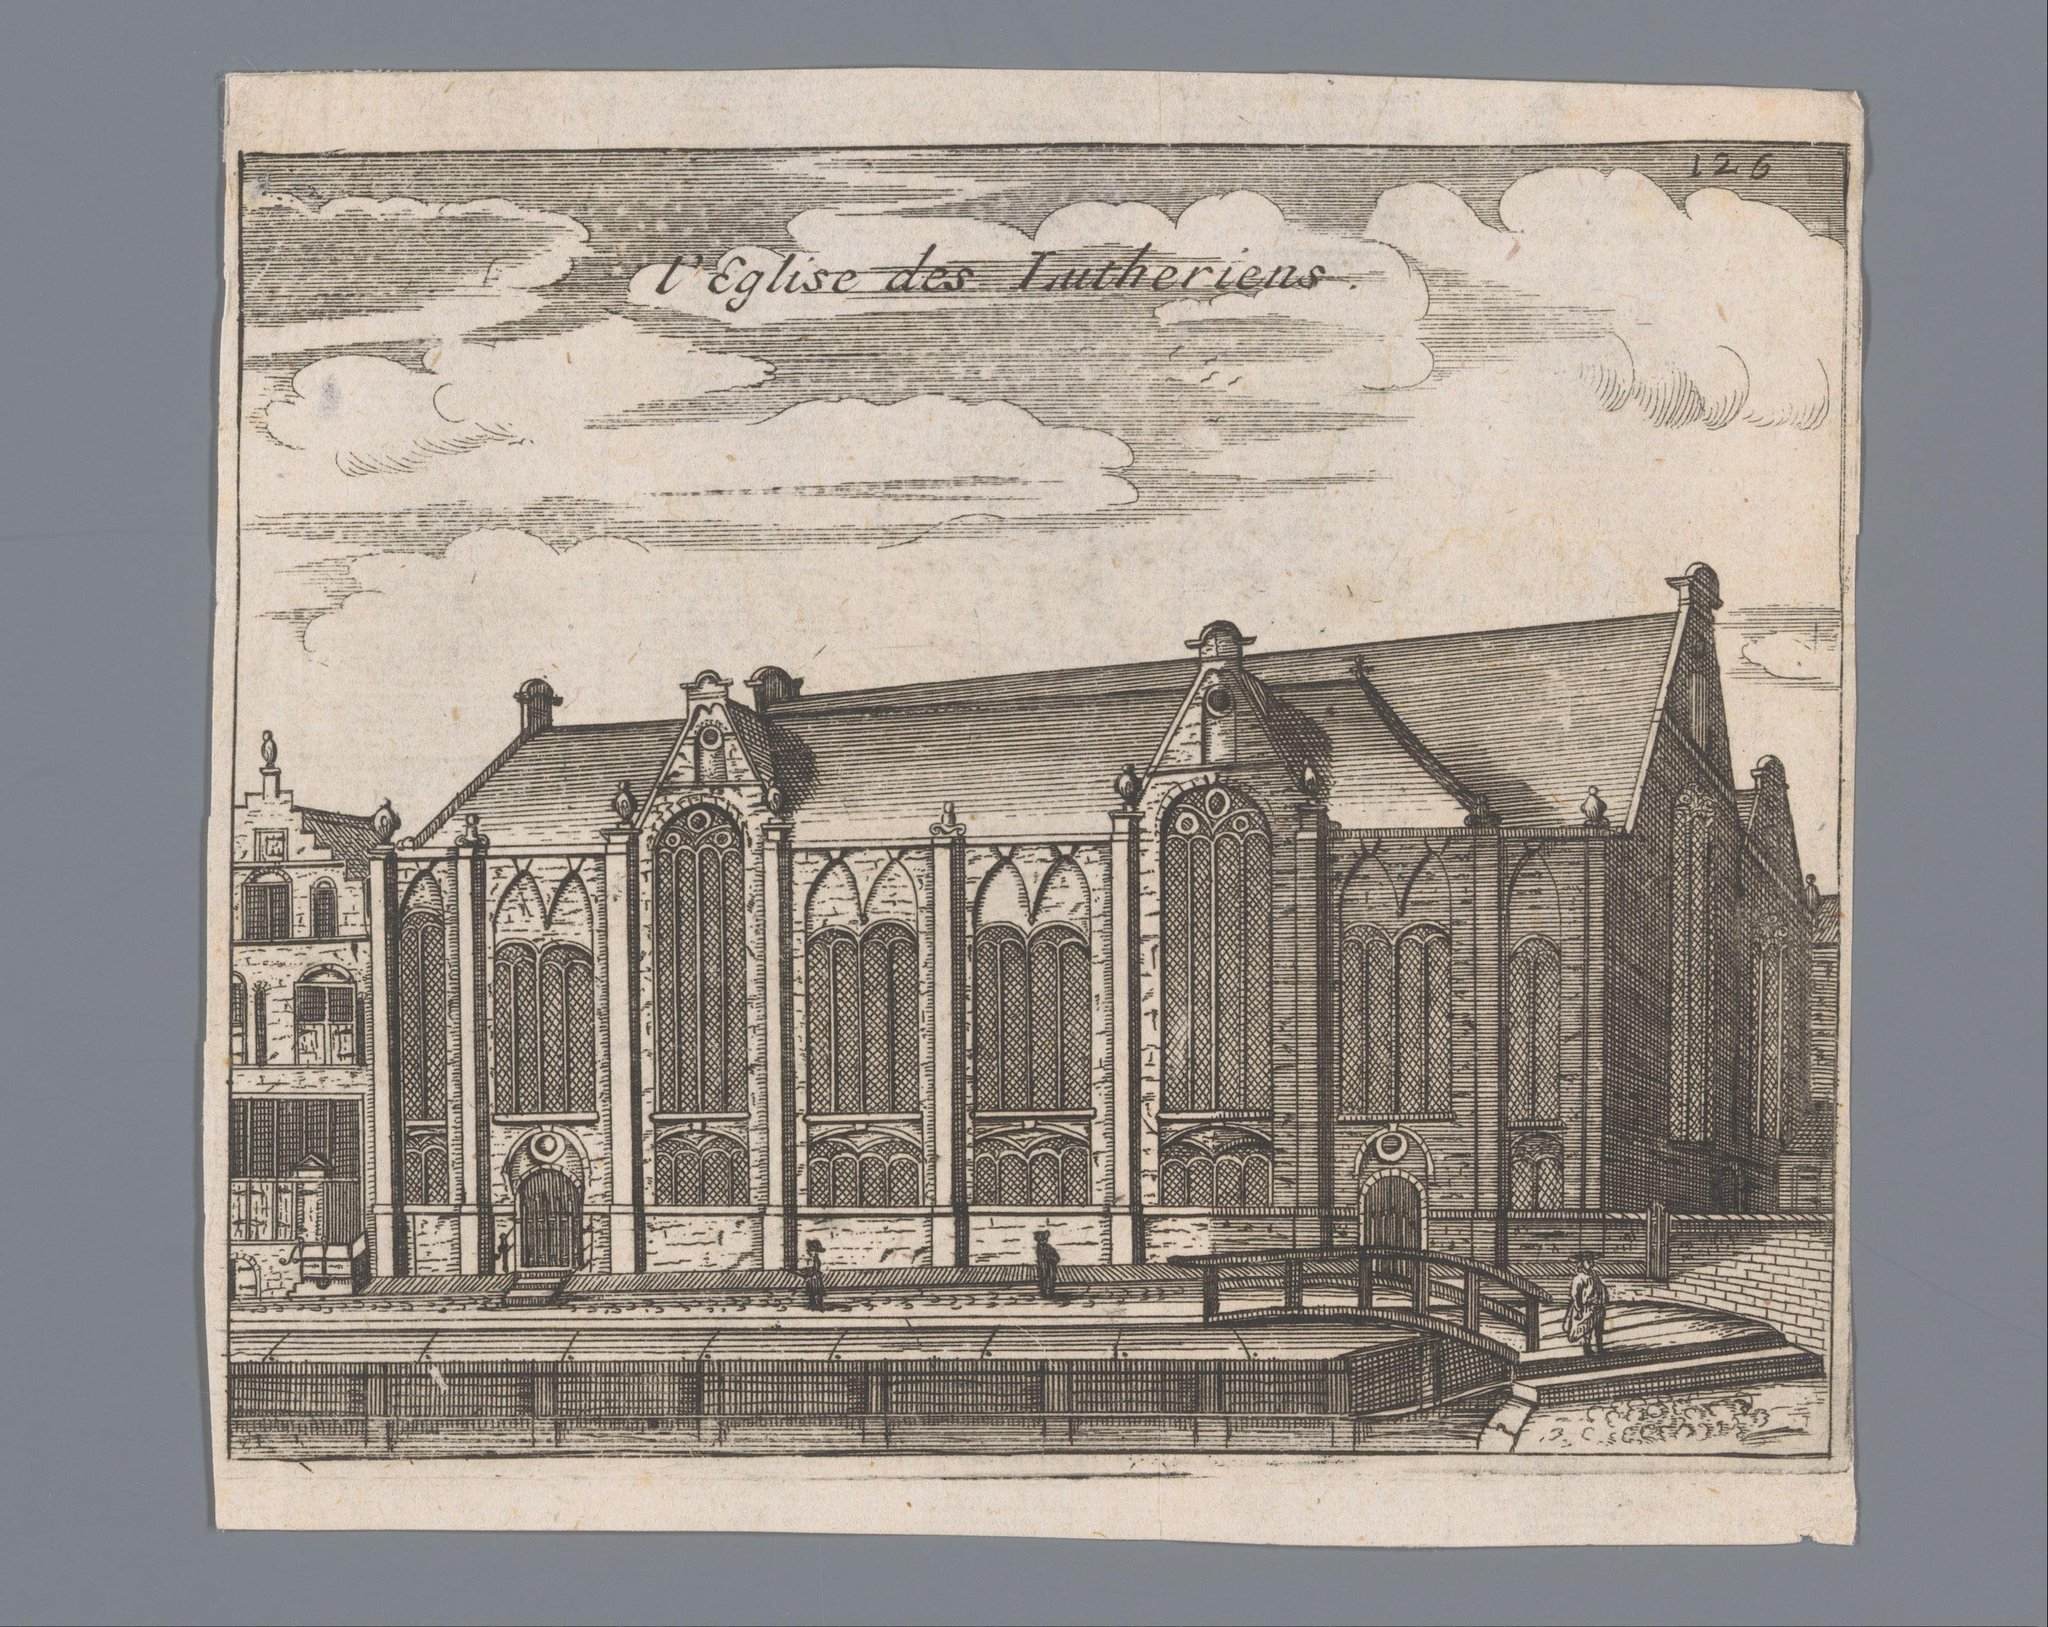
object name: print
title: L'Eglise des Lutheriens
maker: Anonymous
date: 1675-1725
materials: paper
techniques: etching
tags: protestant churches and denominations, amsterdam